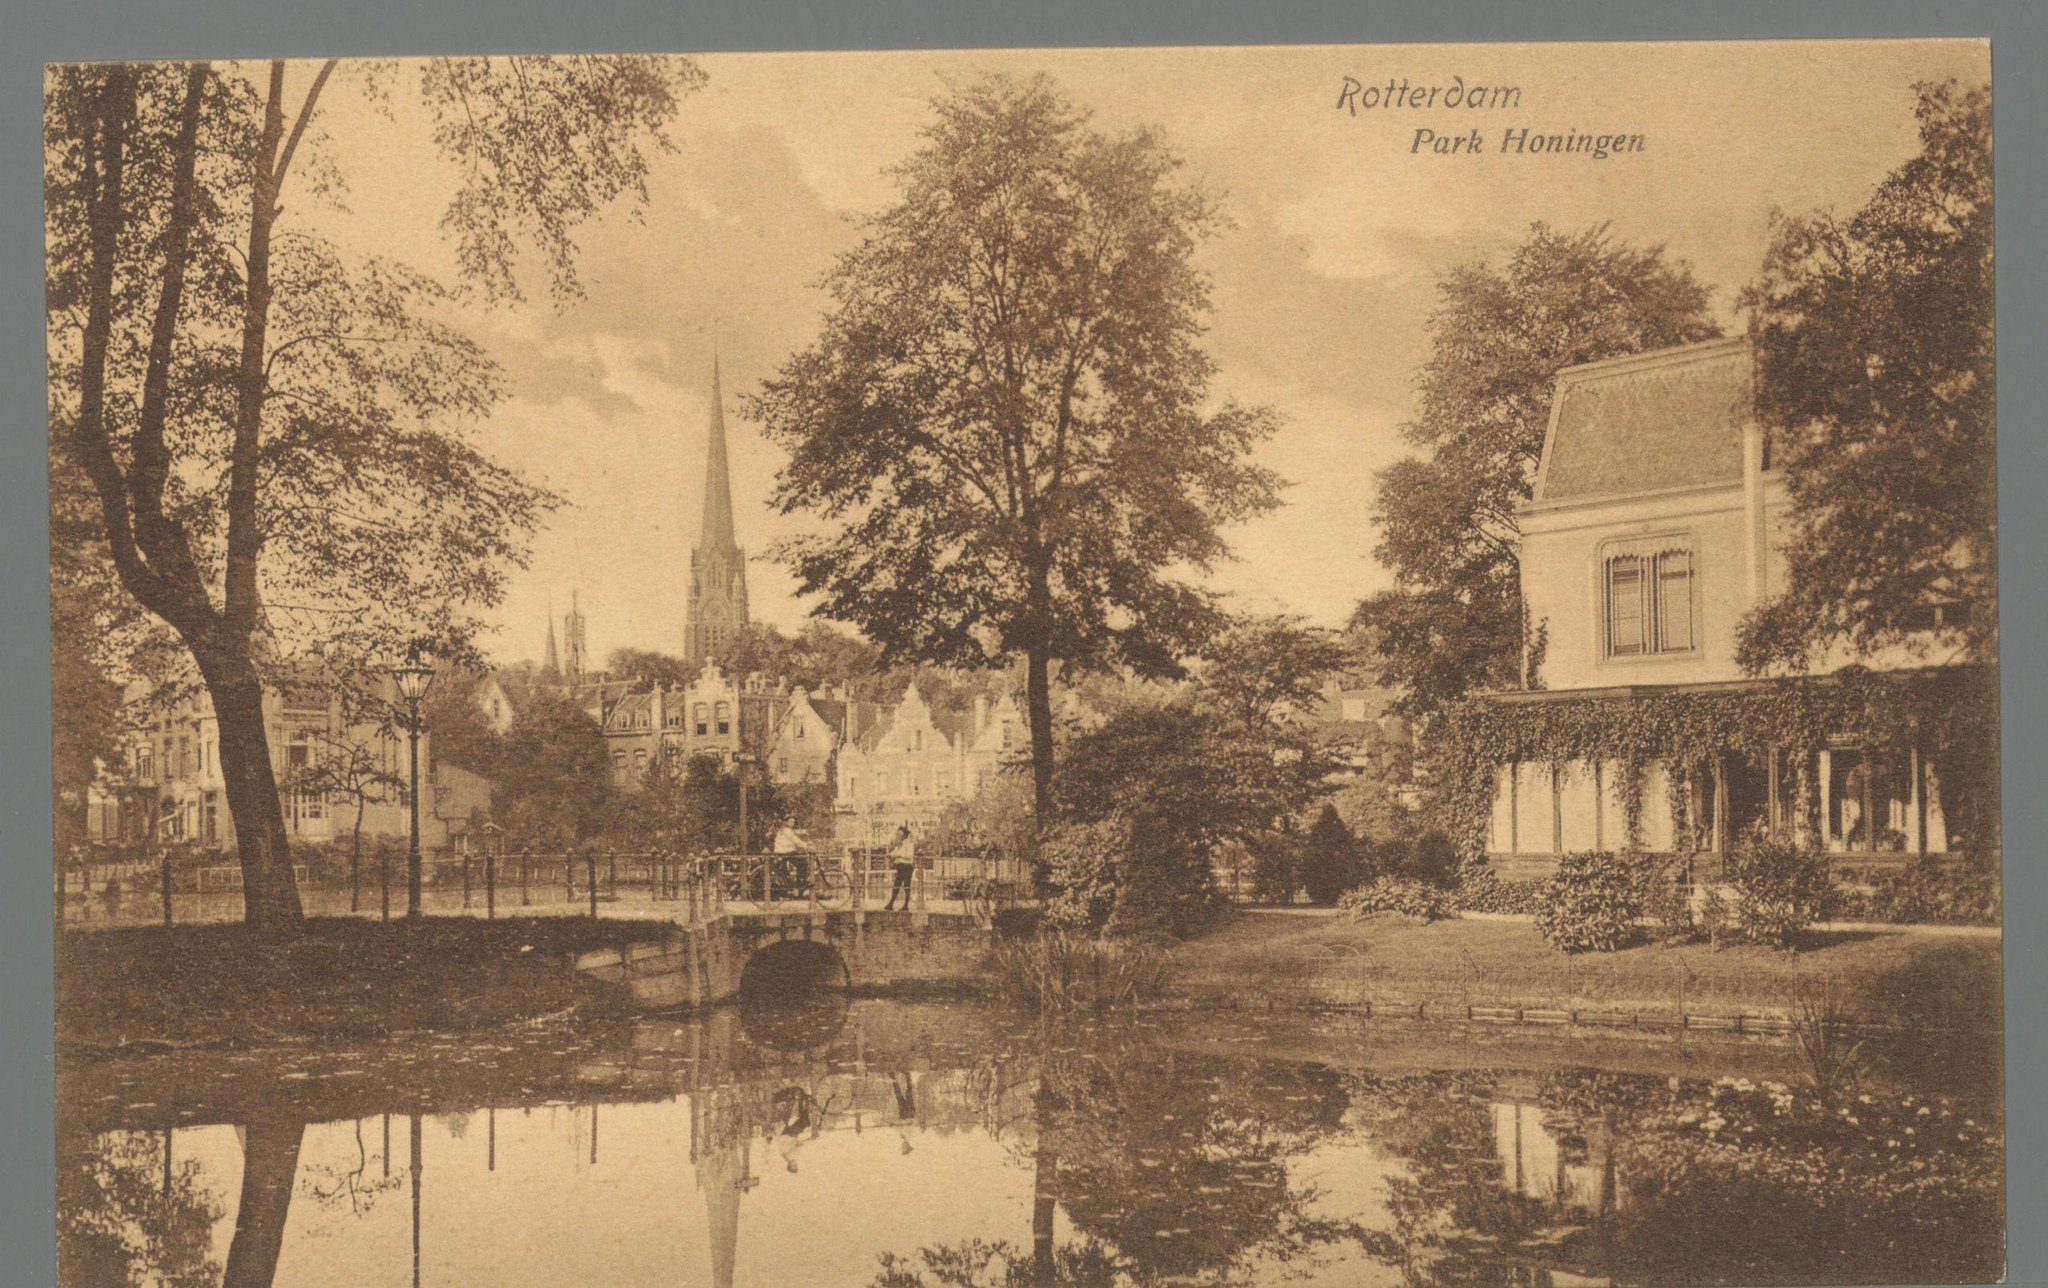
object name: ansichtkaart, prentbriefkaart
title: Rotterdam. Park Honingen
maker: Anonymous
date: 1912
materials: cardboard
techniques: photograph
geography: the hague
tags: park, church (exterior), canals, waters (in city), bridge in city across river, canal, etc., rotterdam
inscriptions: stamp: ‘ako’